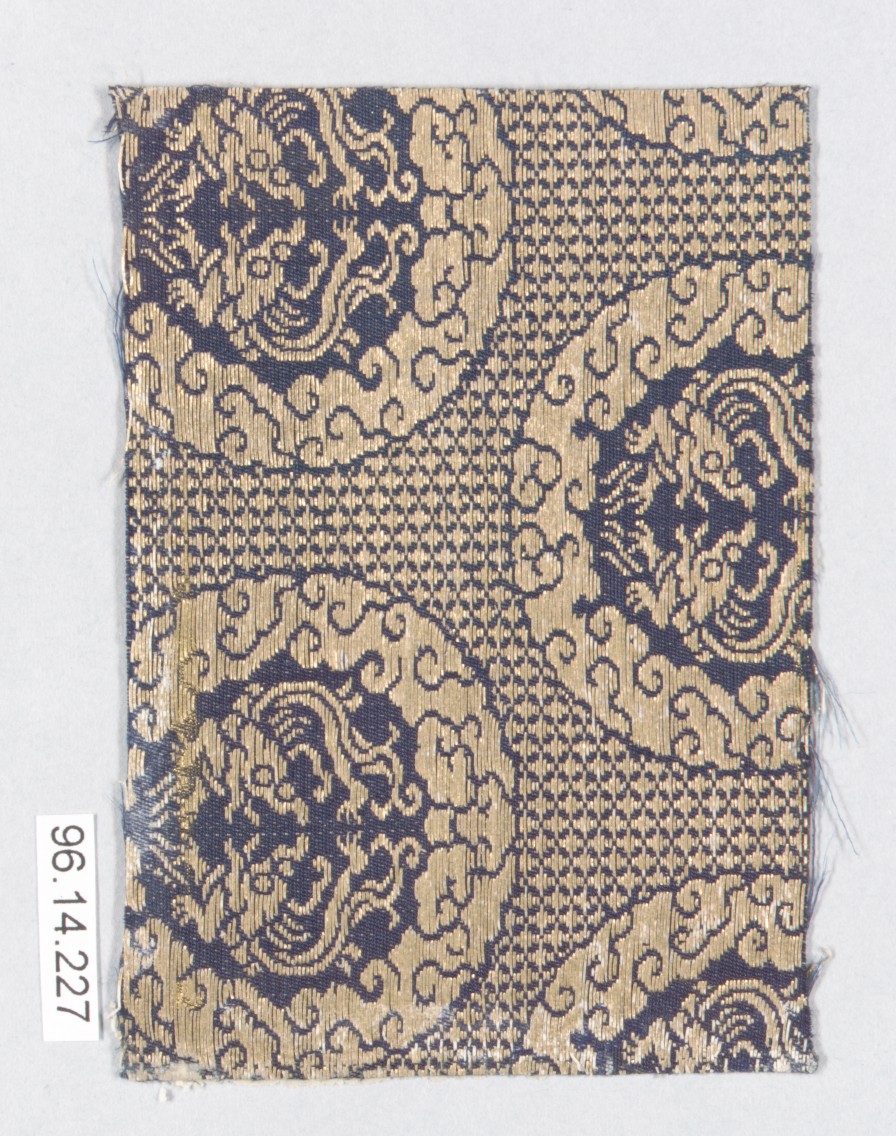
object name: piece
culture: japanese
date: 1701-1900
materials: metal thread, silk